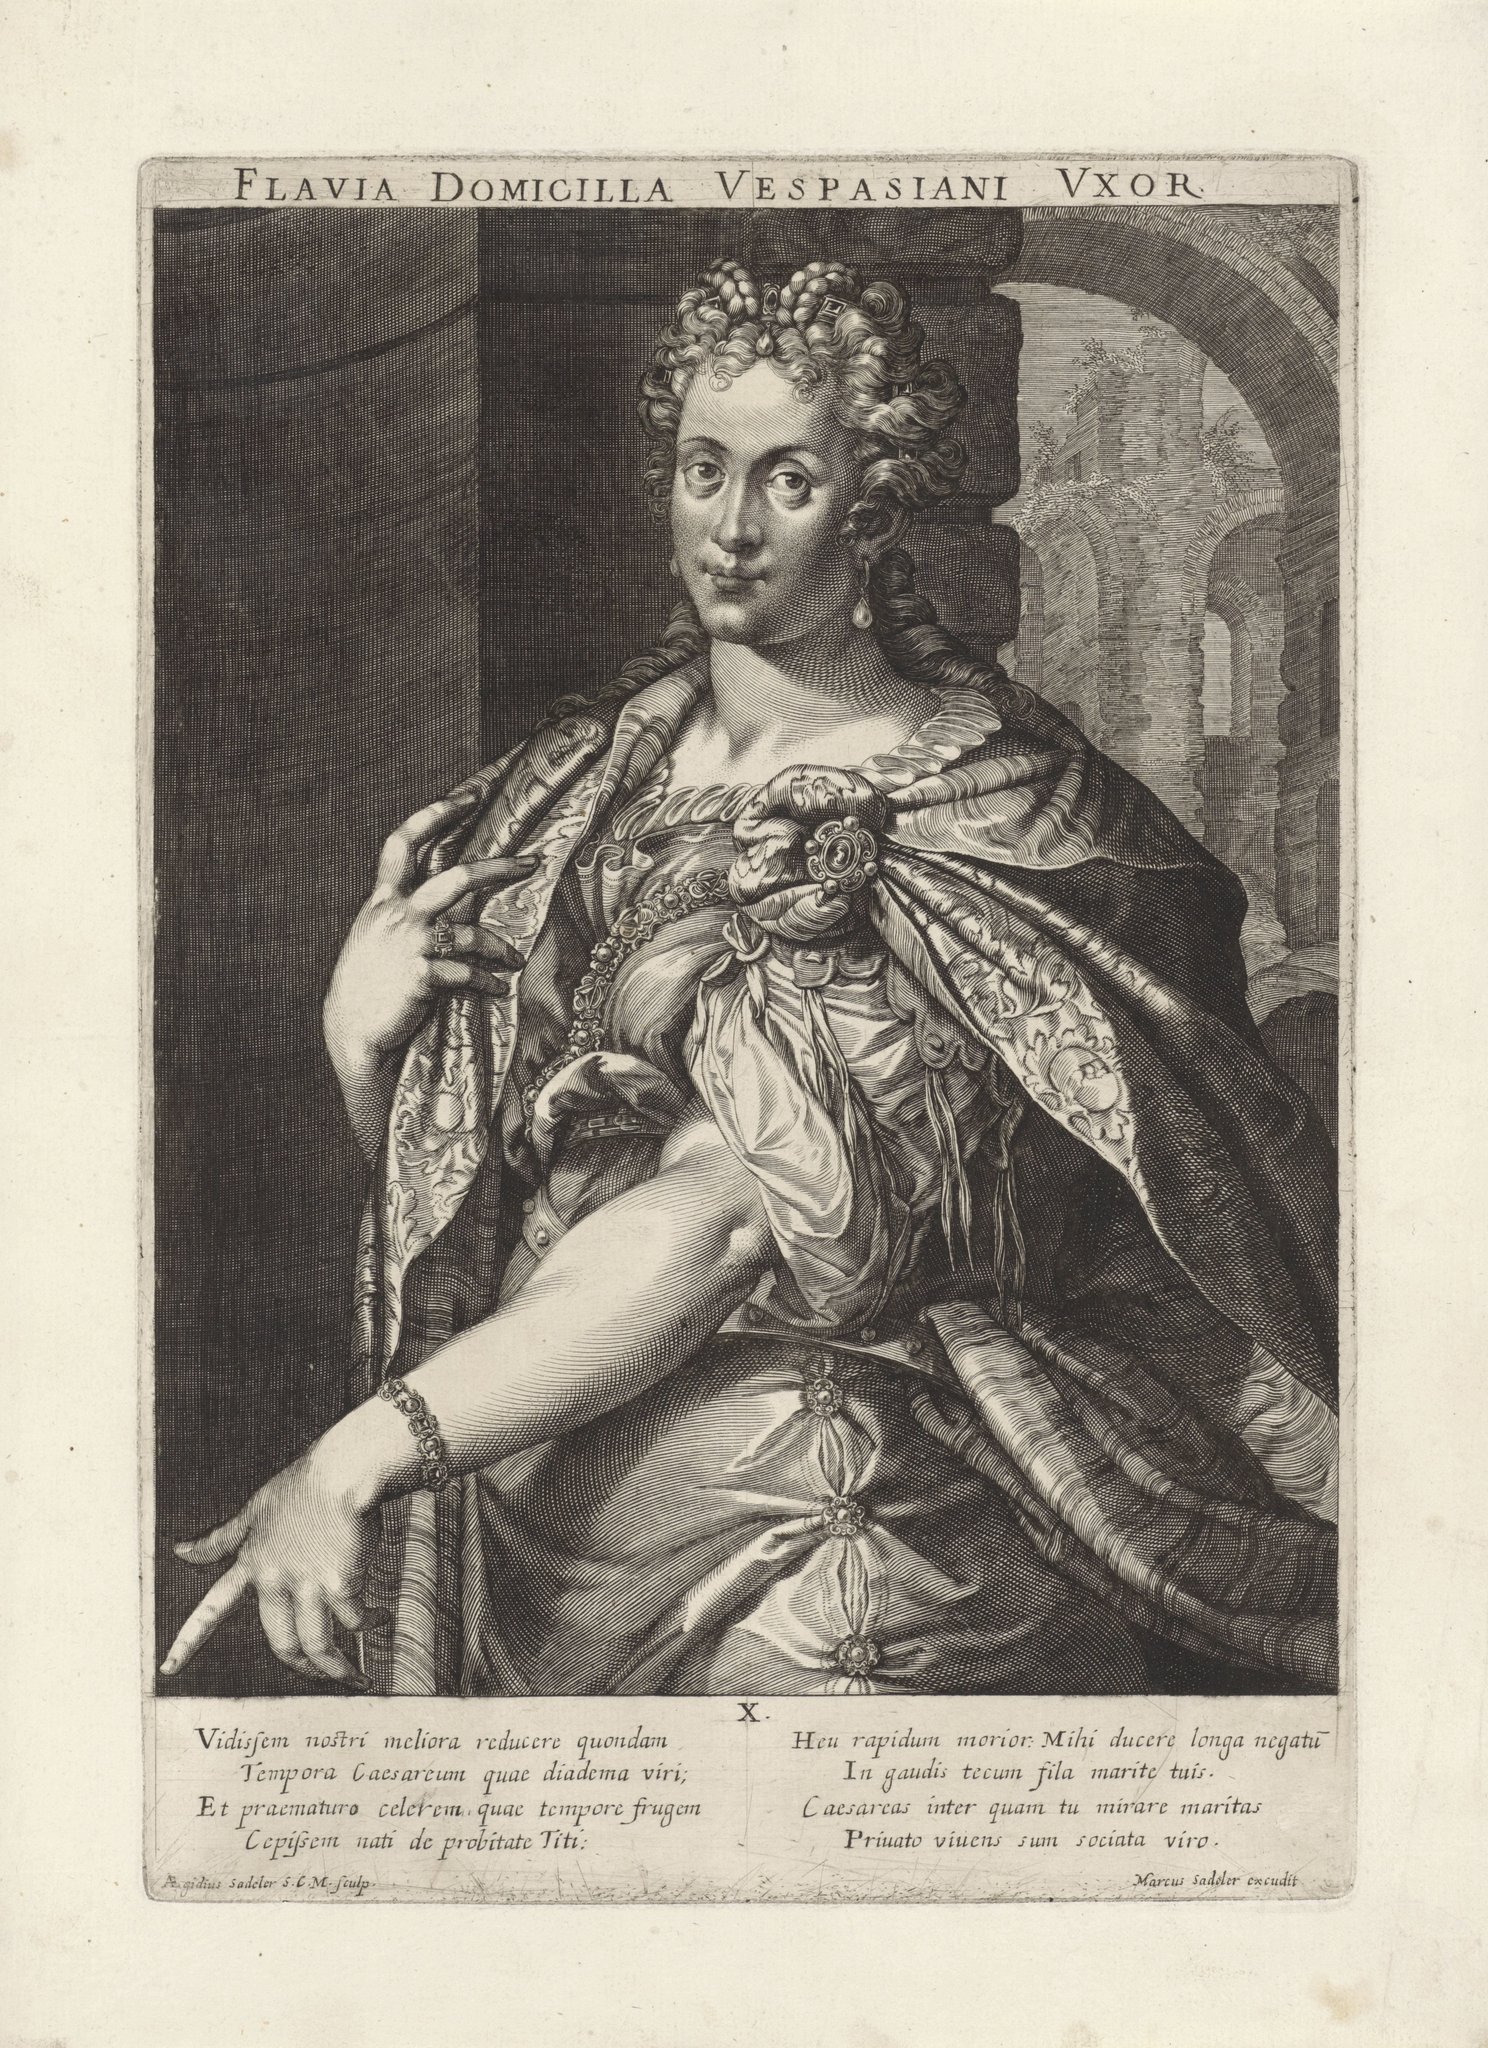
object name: print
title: Beroemde Romeinse vrouwen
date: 1597-1629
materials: paper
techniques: engraving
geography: venice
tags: flavia domitilla maior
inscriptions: collector's mark: Lugt 240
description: Flavia Domitilla maior, eerste vrouw van keizer Vespasianus.